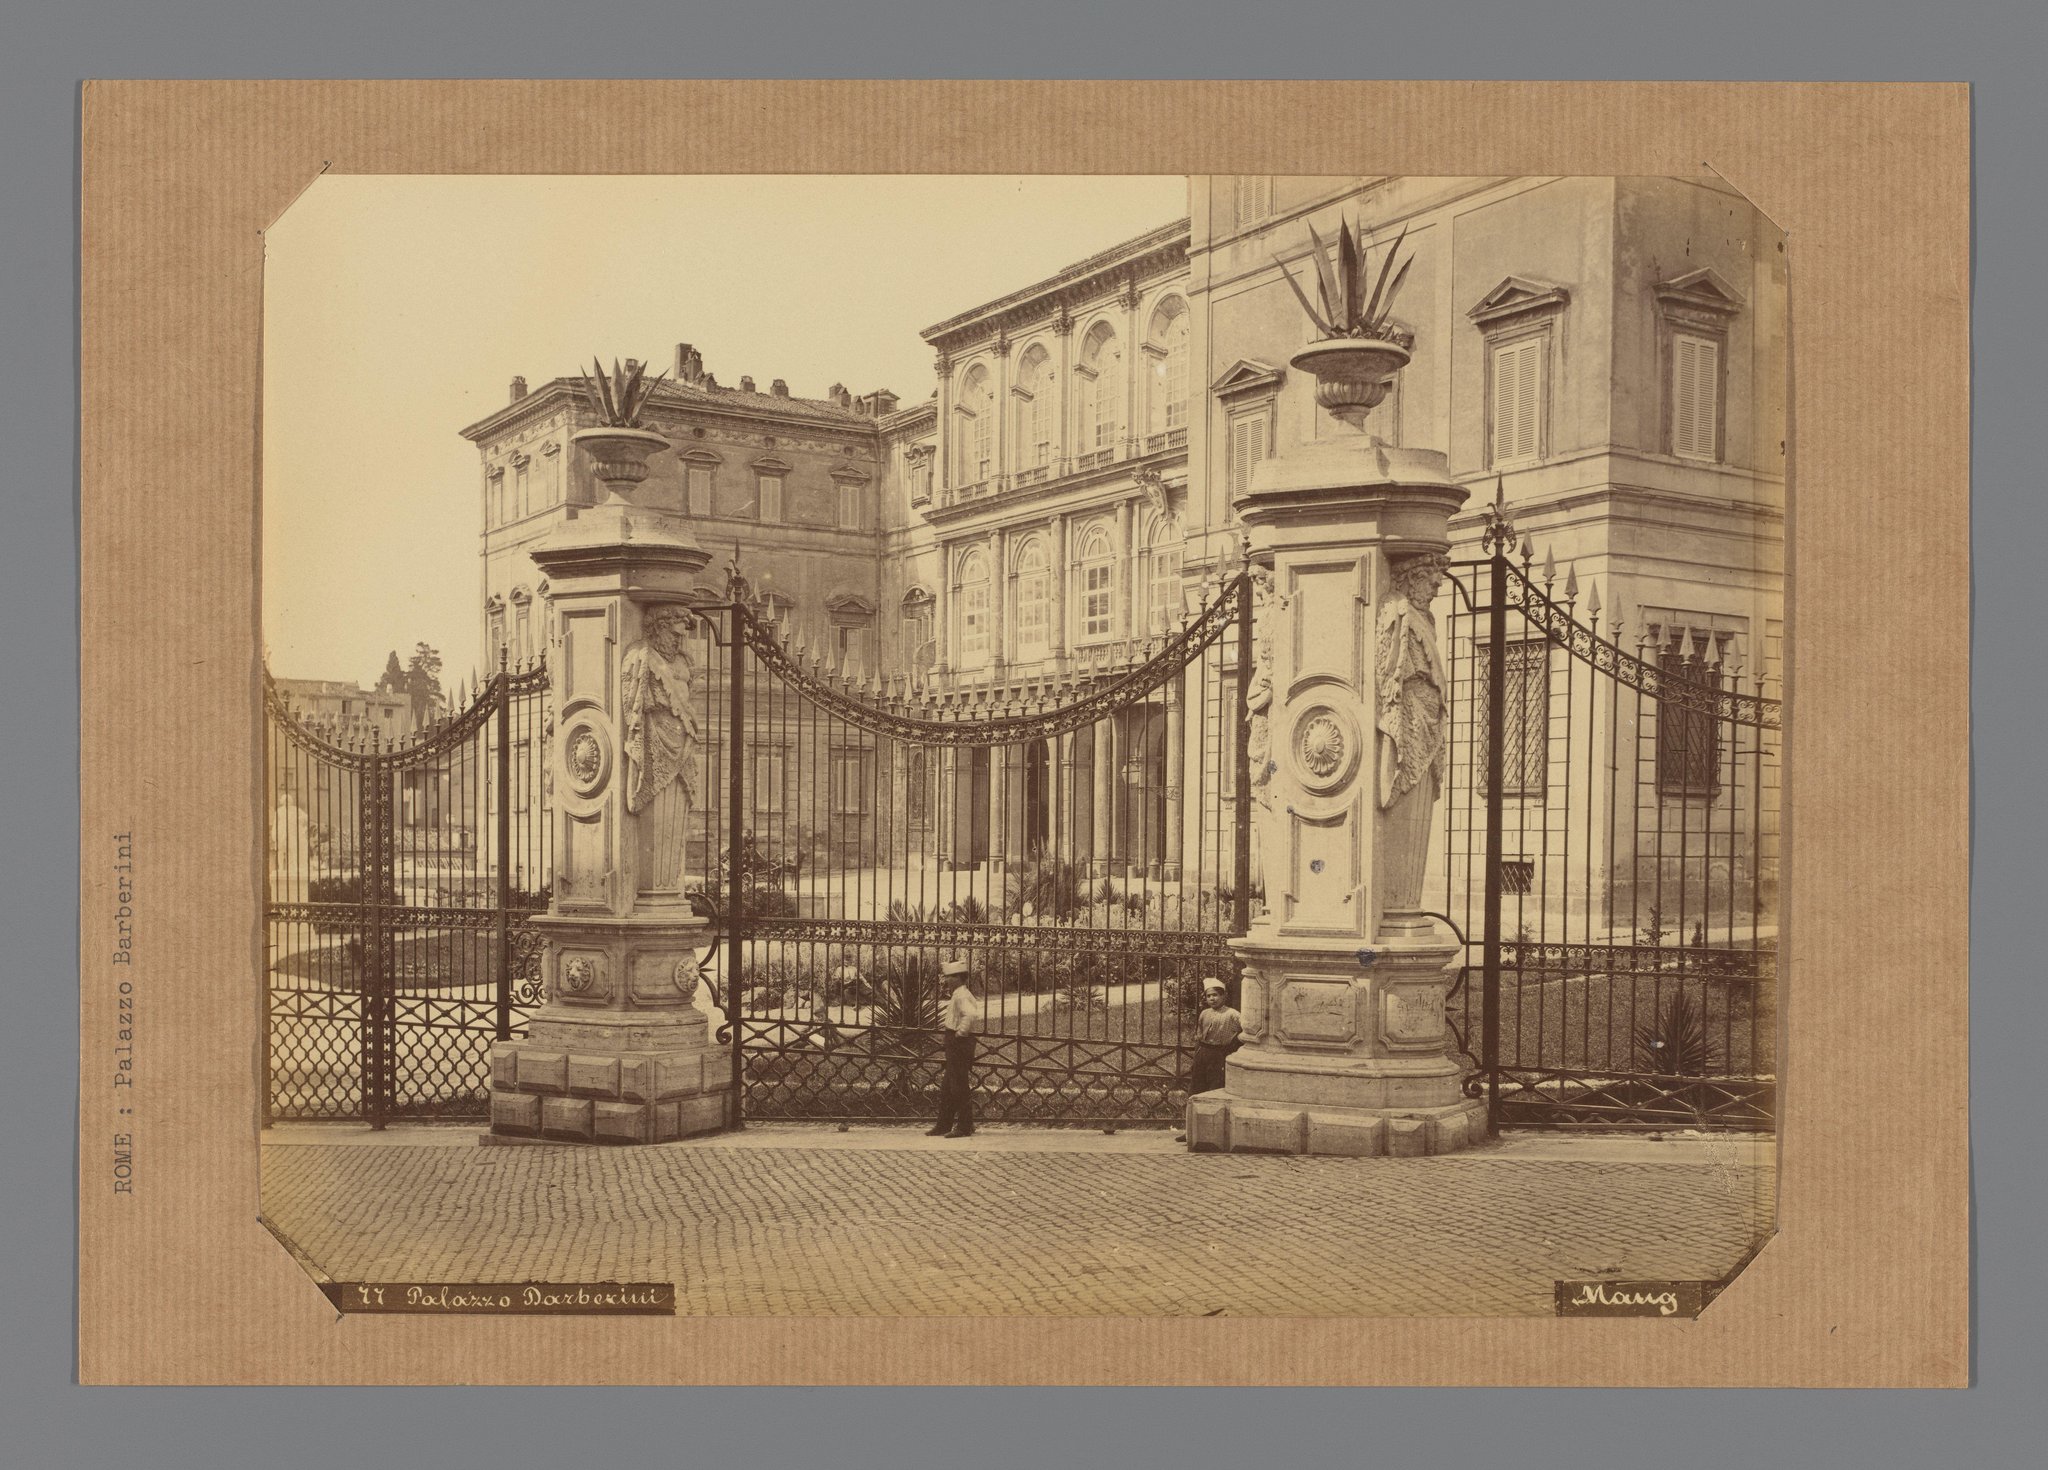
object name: photograph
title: Rome: Palazzo Barberini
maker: Anonymous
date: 1850-1899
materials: paper, photographic support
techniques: albumen print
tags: palazzo barberini